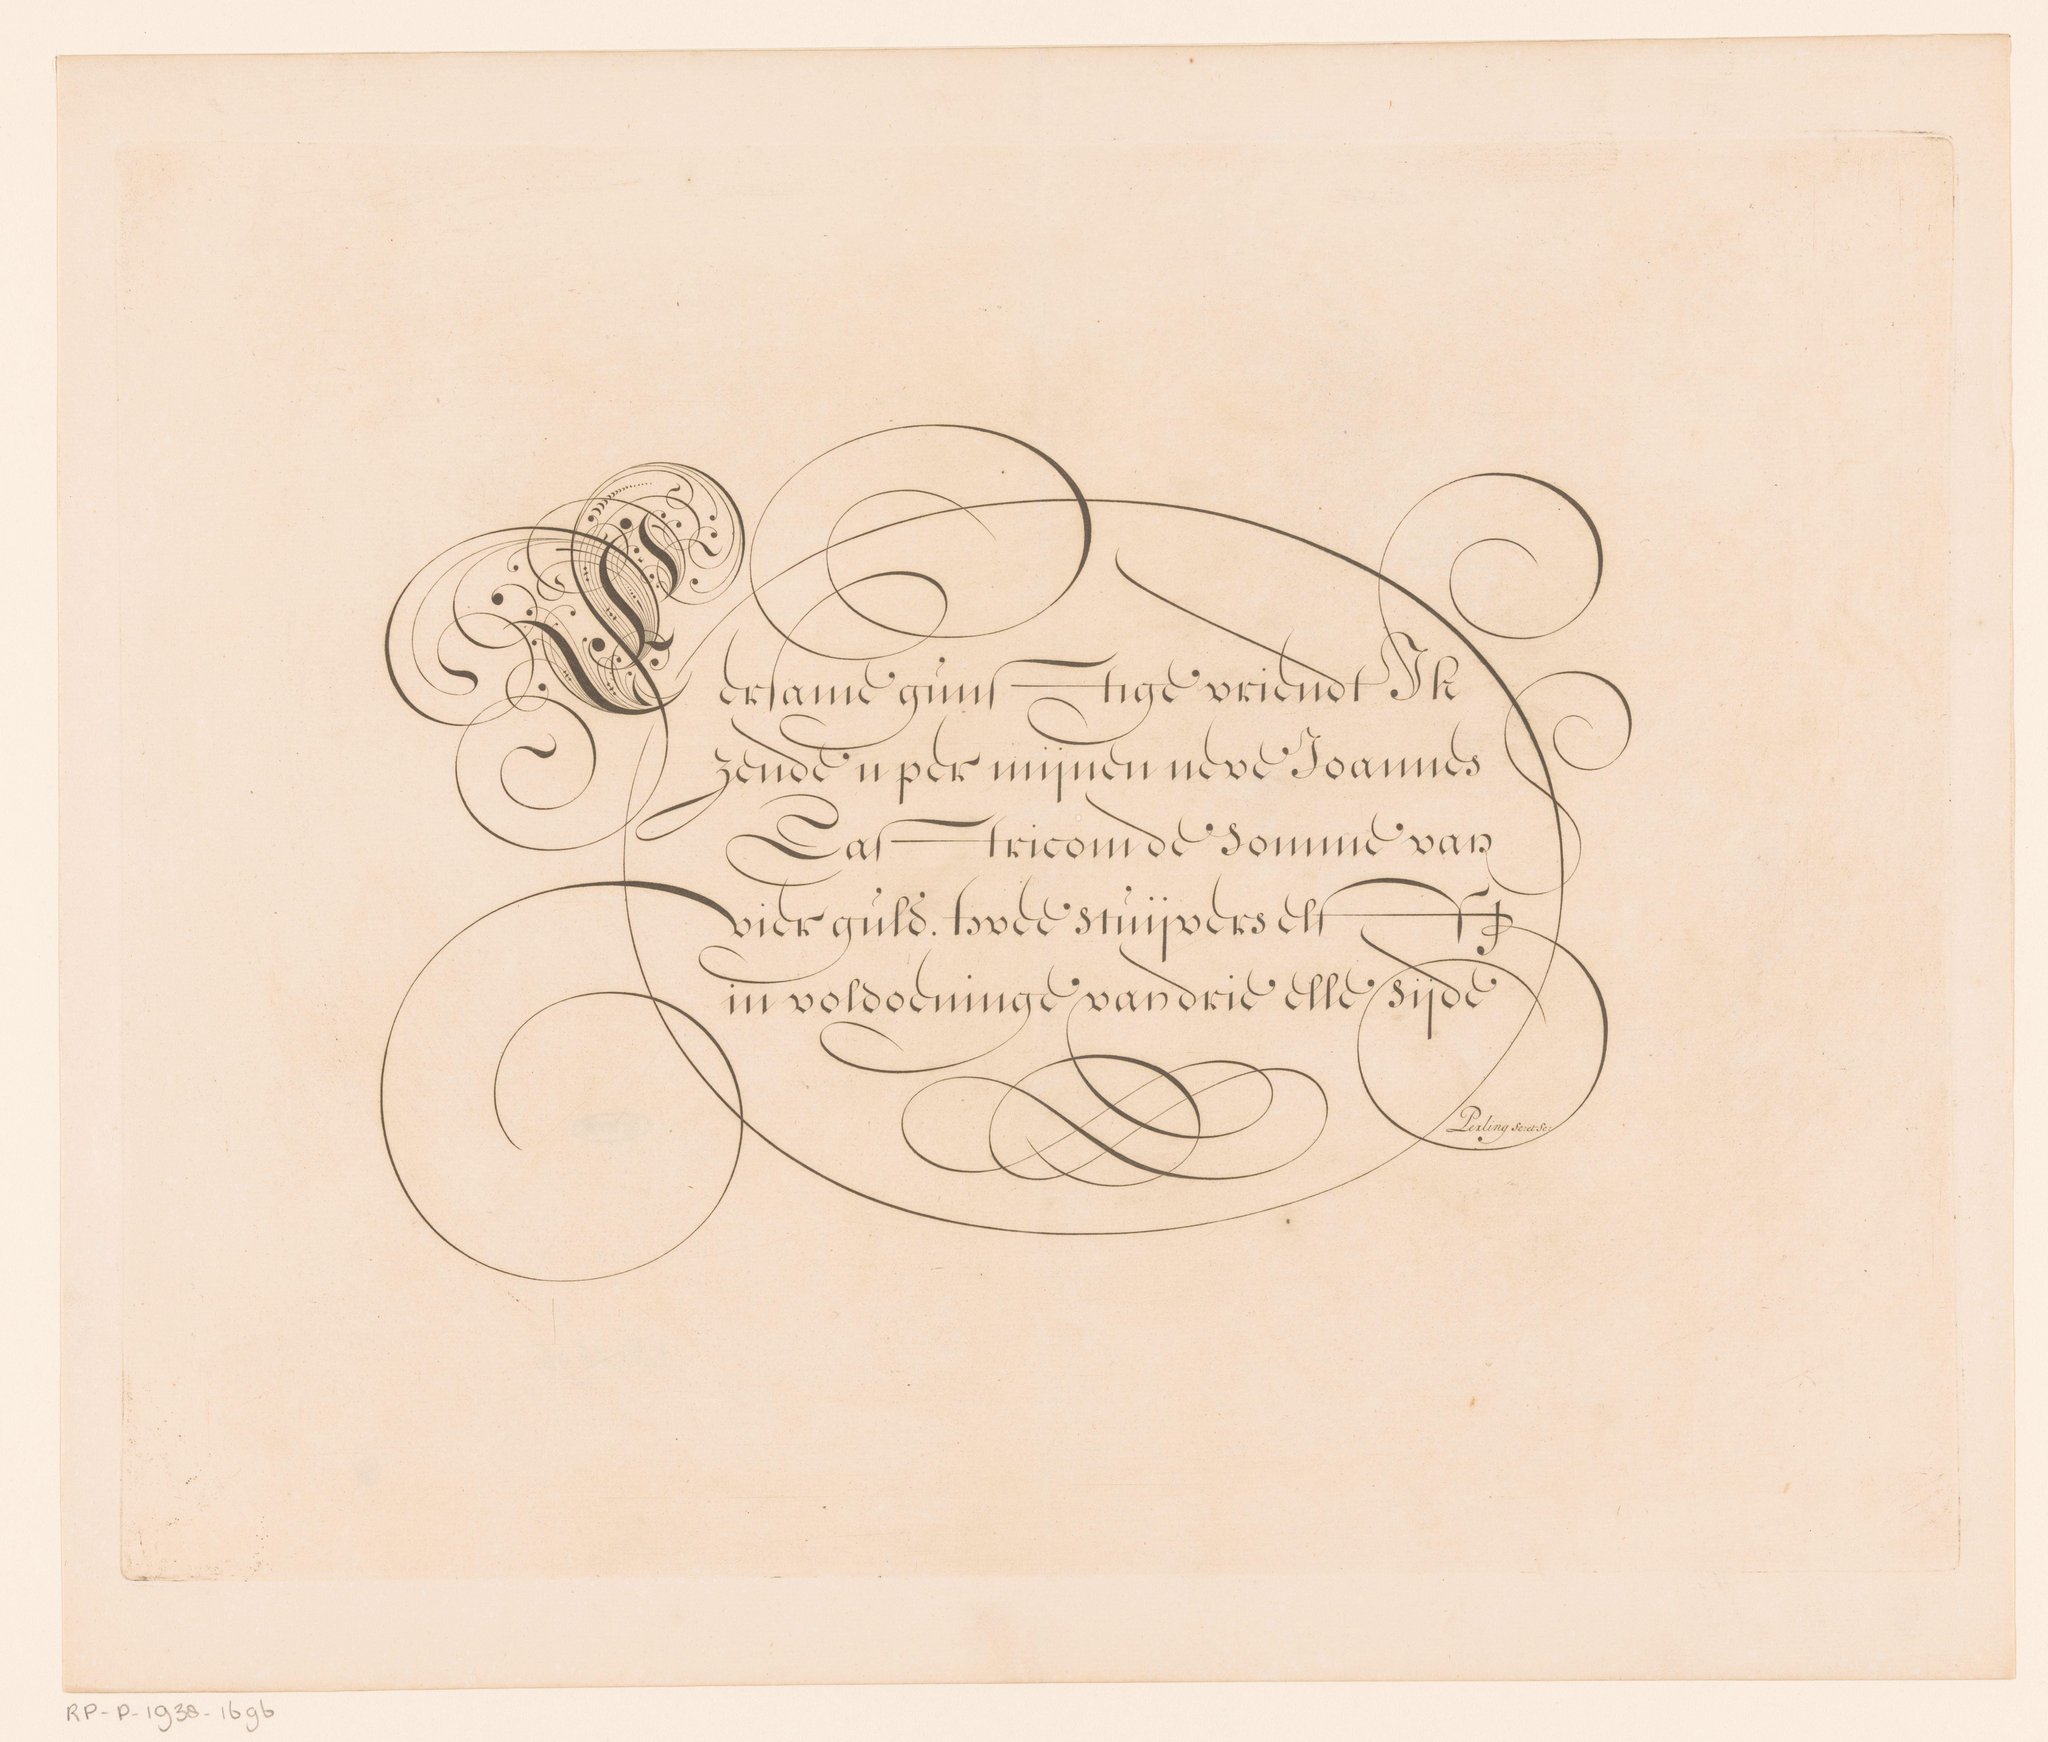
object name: ornament print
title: Schrijfvoorbeeld: Eersame gunstige vriendt (...)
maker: ambrosius perling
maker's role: print maker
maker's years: 1657-1718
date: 1667-1718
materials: paper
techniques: engraving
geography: amsterdam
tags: calligraphy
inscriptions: collector's mark: Lugt 2228, watermark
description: Schrijfvoorbeeld met vijf regels tekst in het Nederlands: Eersame gunstige vriendt Ik zende u per mijnen neve ...